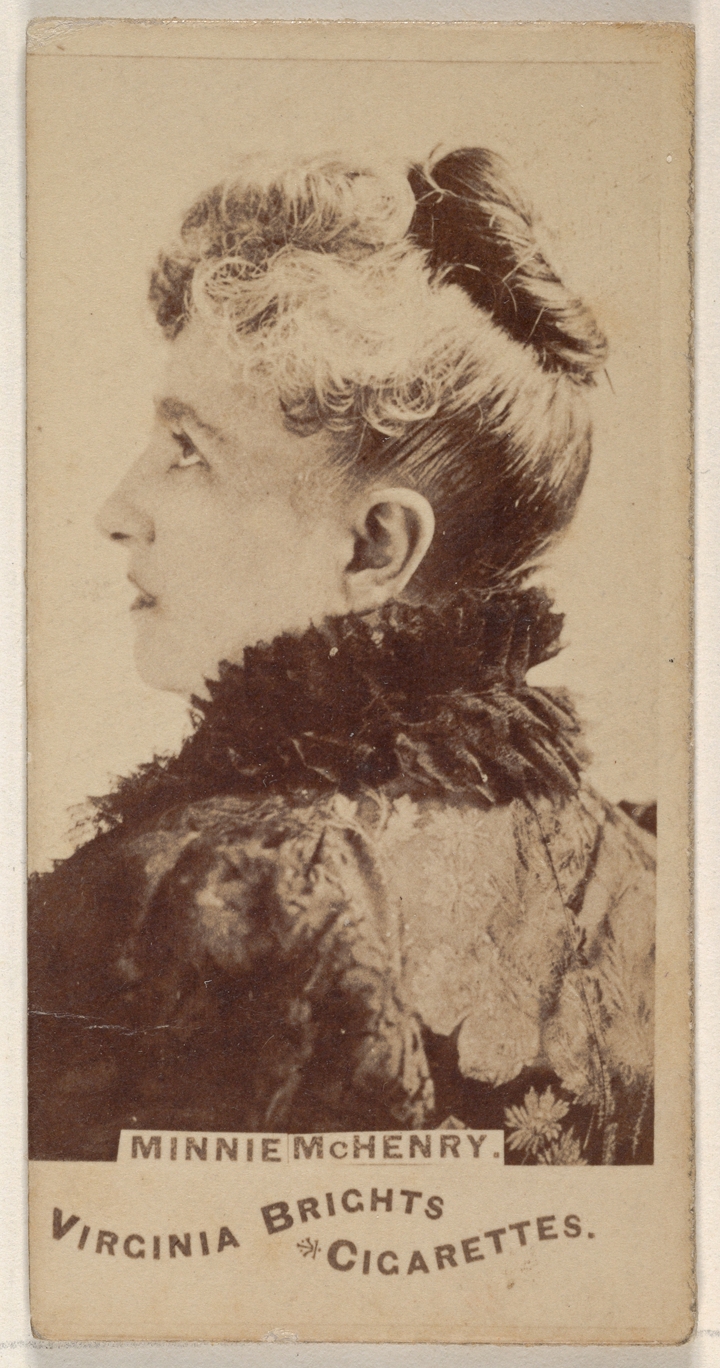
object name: photograph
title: Minnie McHenry, from the Actors and Actresses series (N45, Type 1) for Virginia Brights Cigarettes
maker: allen & ginter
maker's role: publisher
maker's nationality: american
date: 1888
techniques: albumen silver print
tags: portraits,women,actresses